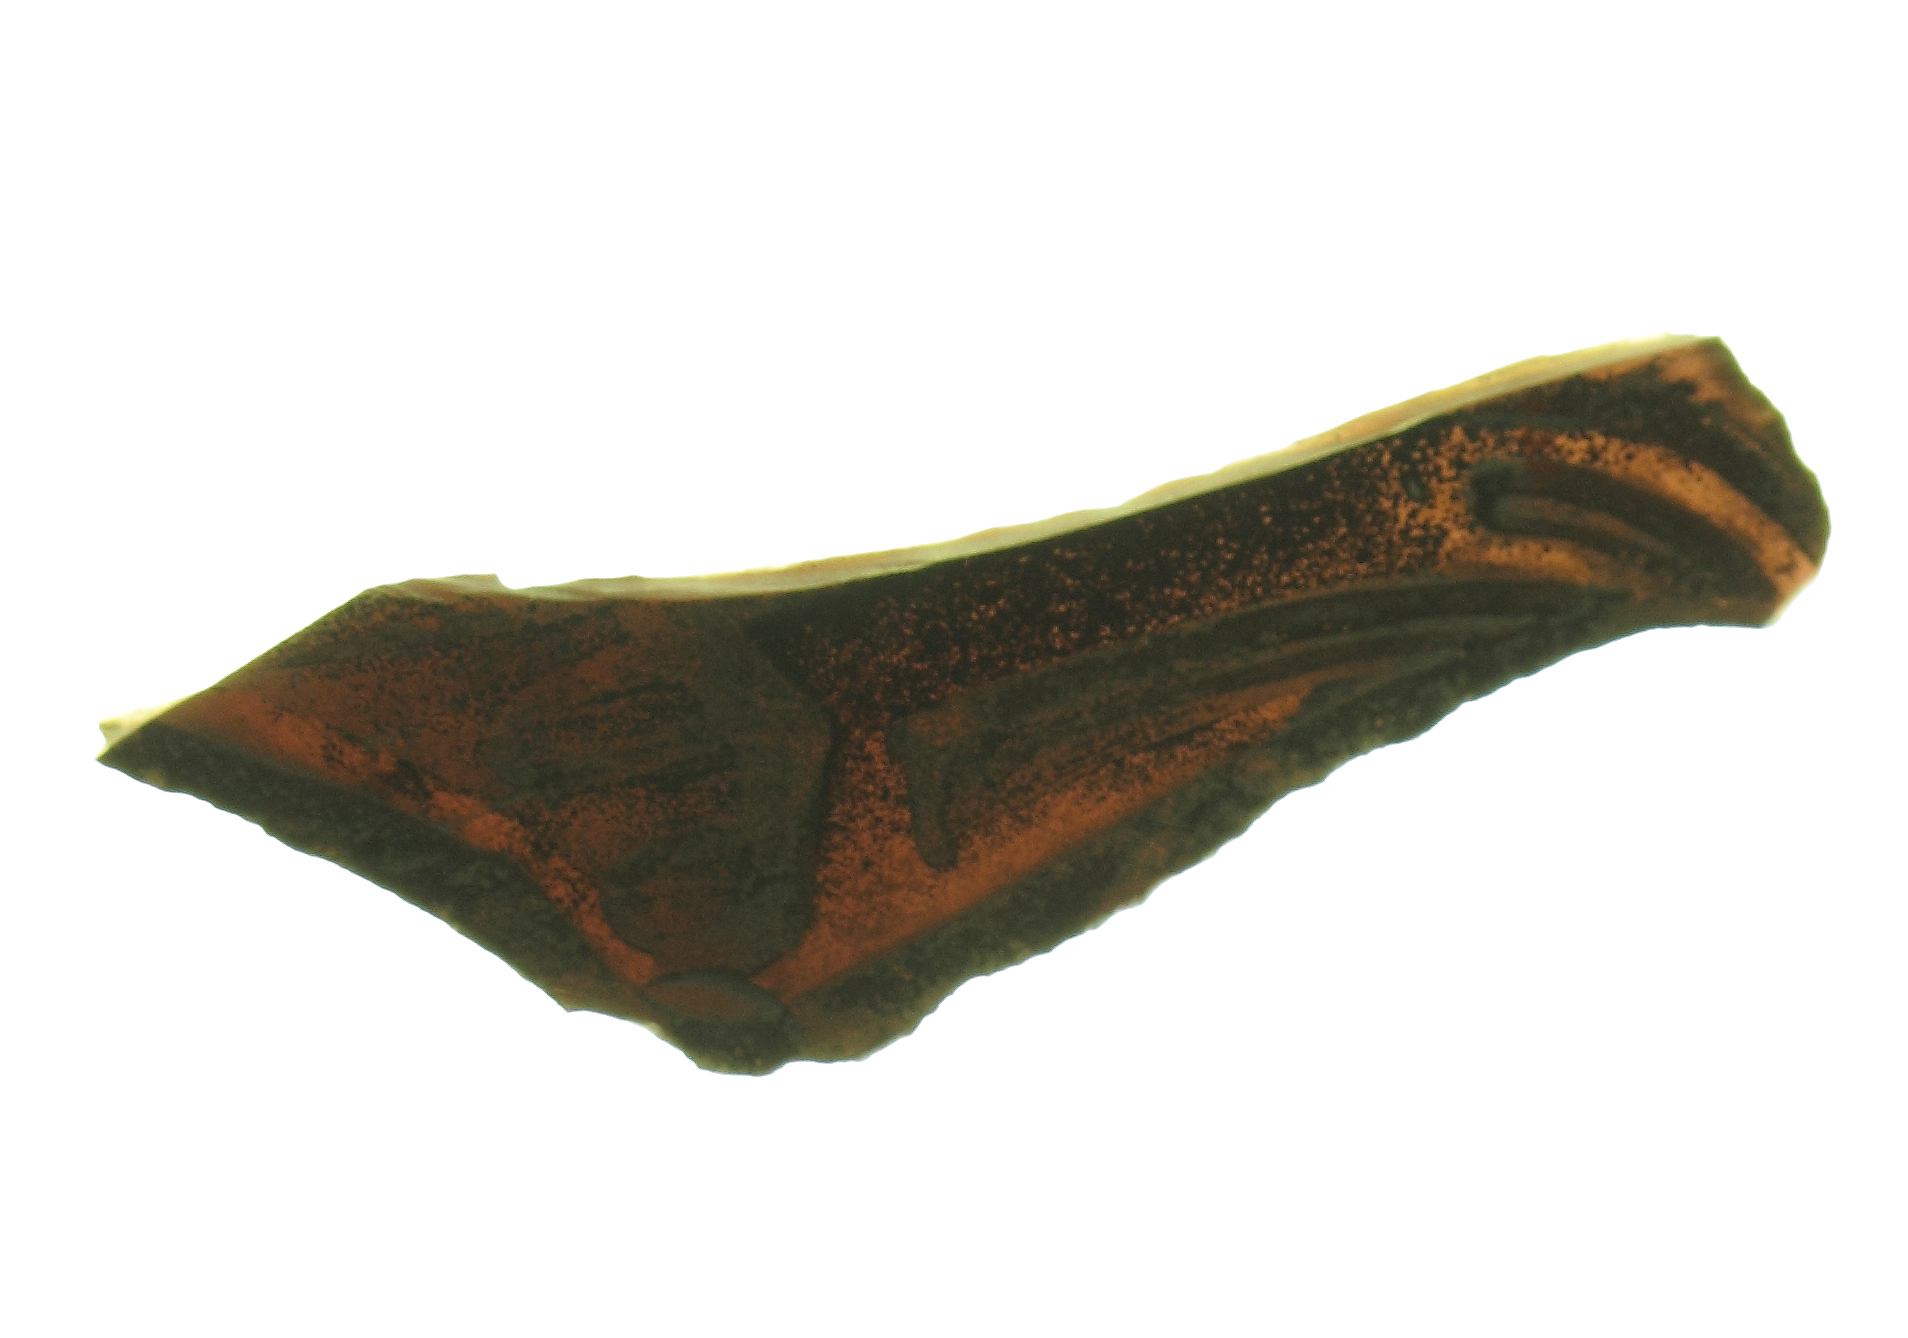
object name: fragment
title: Glass Fragment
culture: french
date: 1101-1400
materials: glass, metal, paint